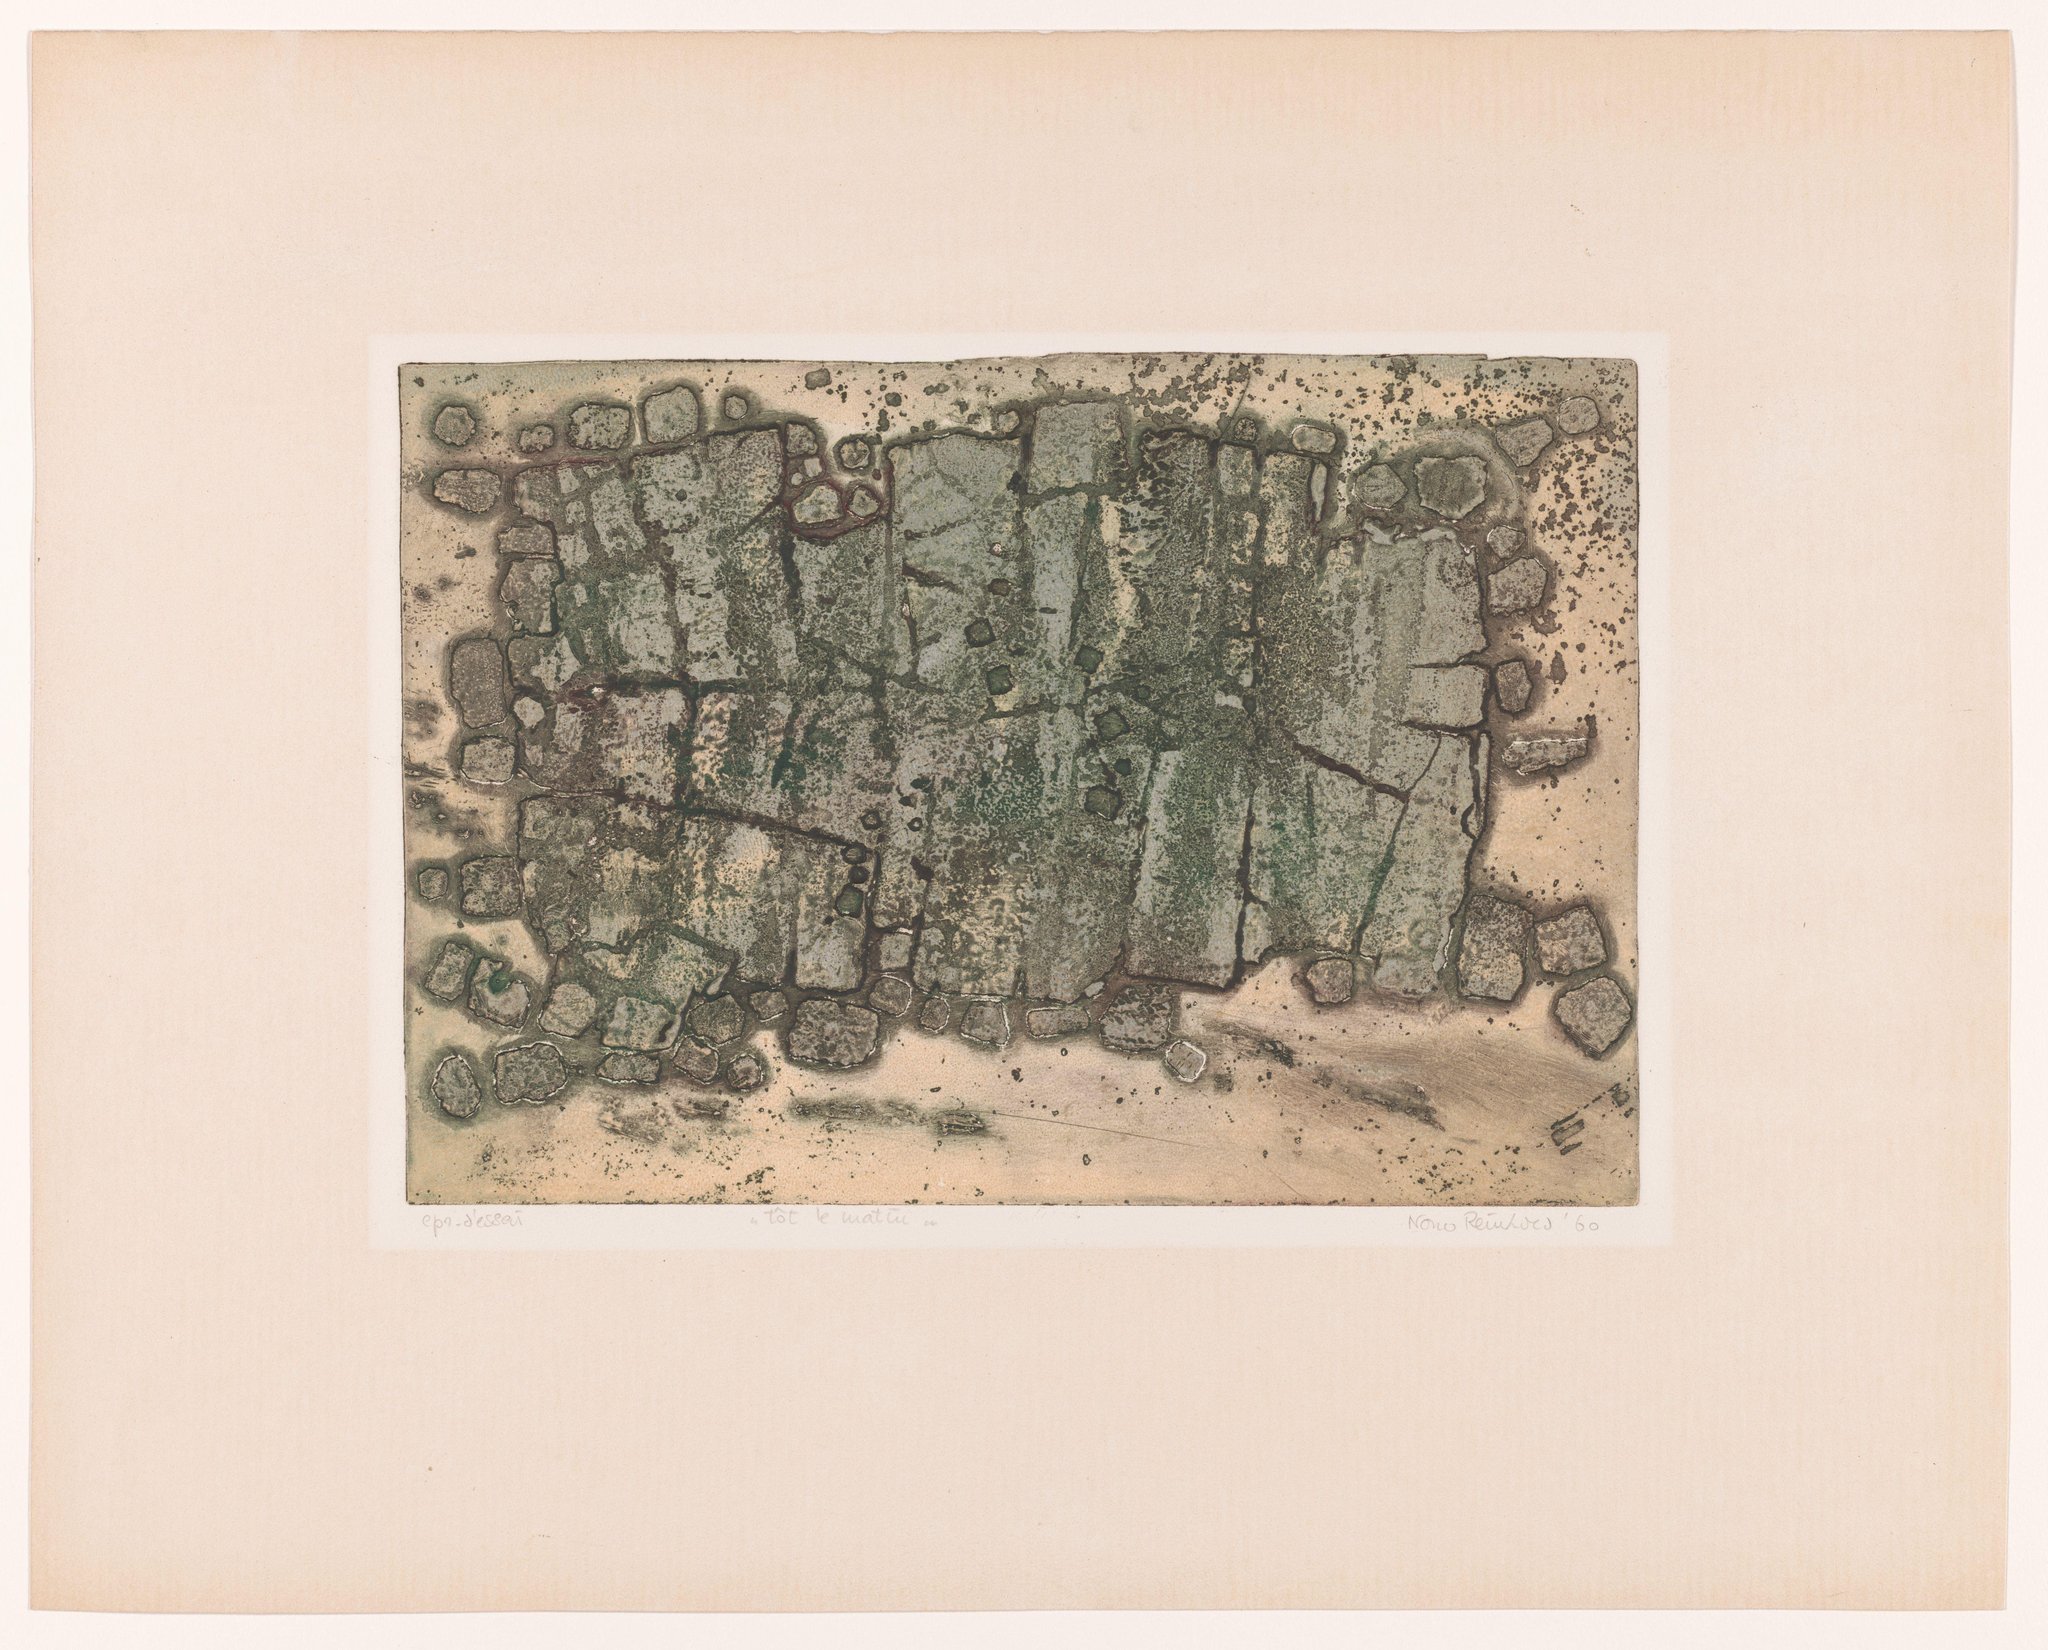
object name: print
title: Tôt le matin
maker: nono reinhold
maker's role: print maker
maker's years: 1929-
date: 1960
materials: paper, ink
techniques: aquatint, relief print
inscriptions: signature and date: ‘Nono Reinhold '60’, title: ‘"Tôt le matin"’, inscription: ‘epr. d'essai’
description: Groene rechthoekige rotsen met daaromheen ronde rotsen, tegen een beige achtergrond.